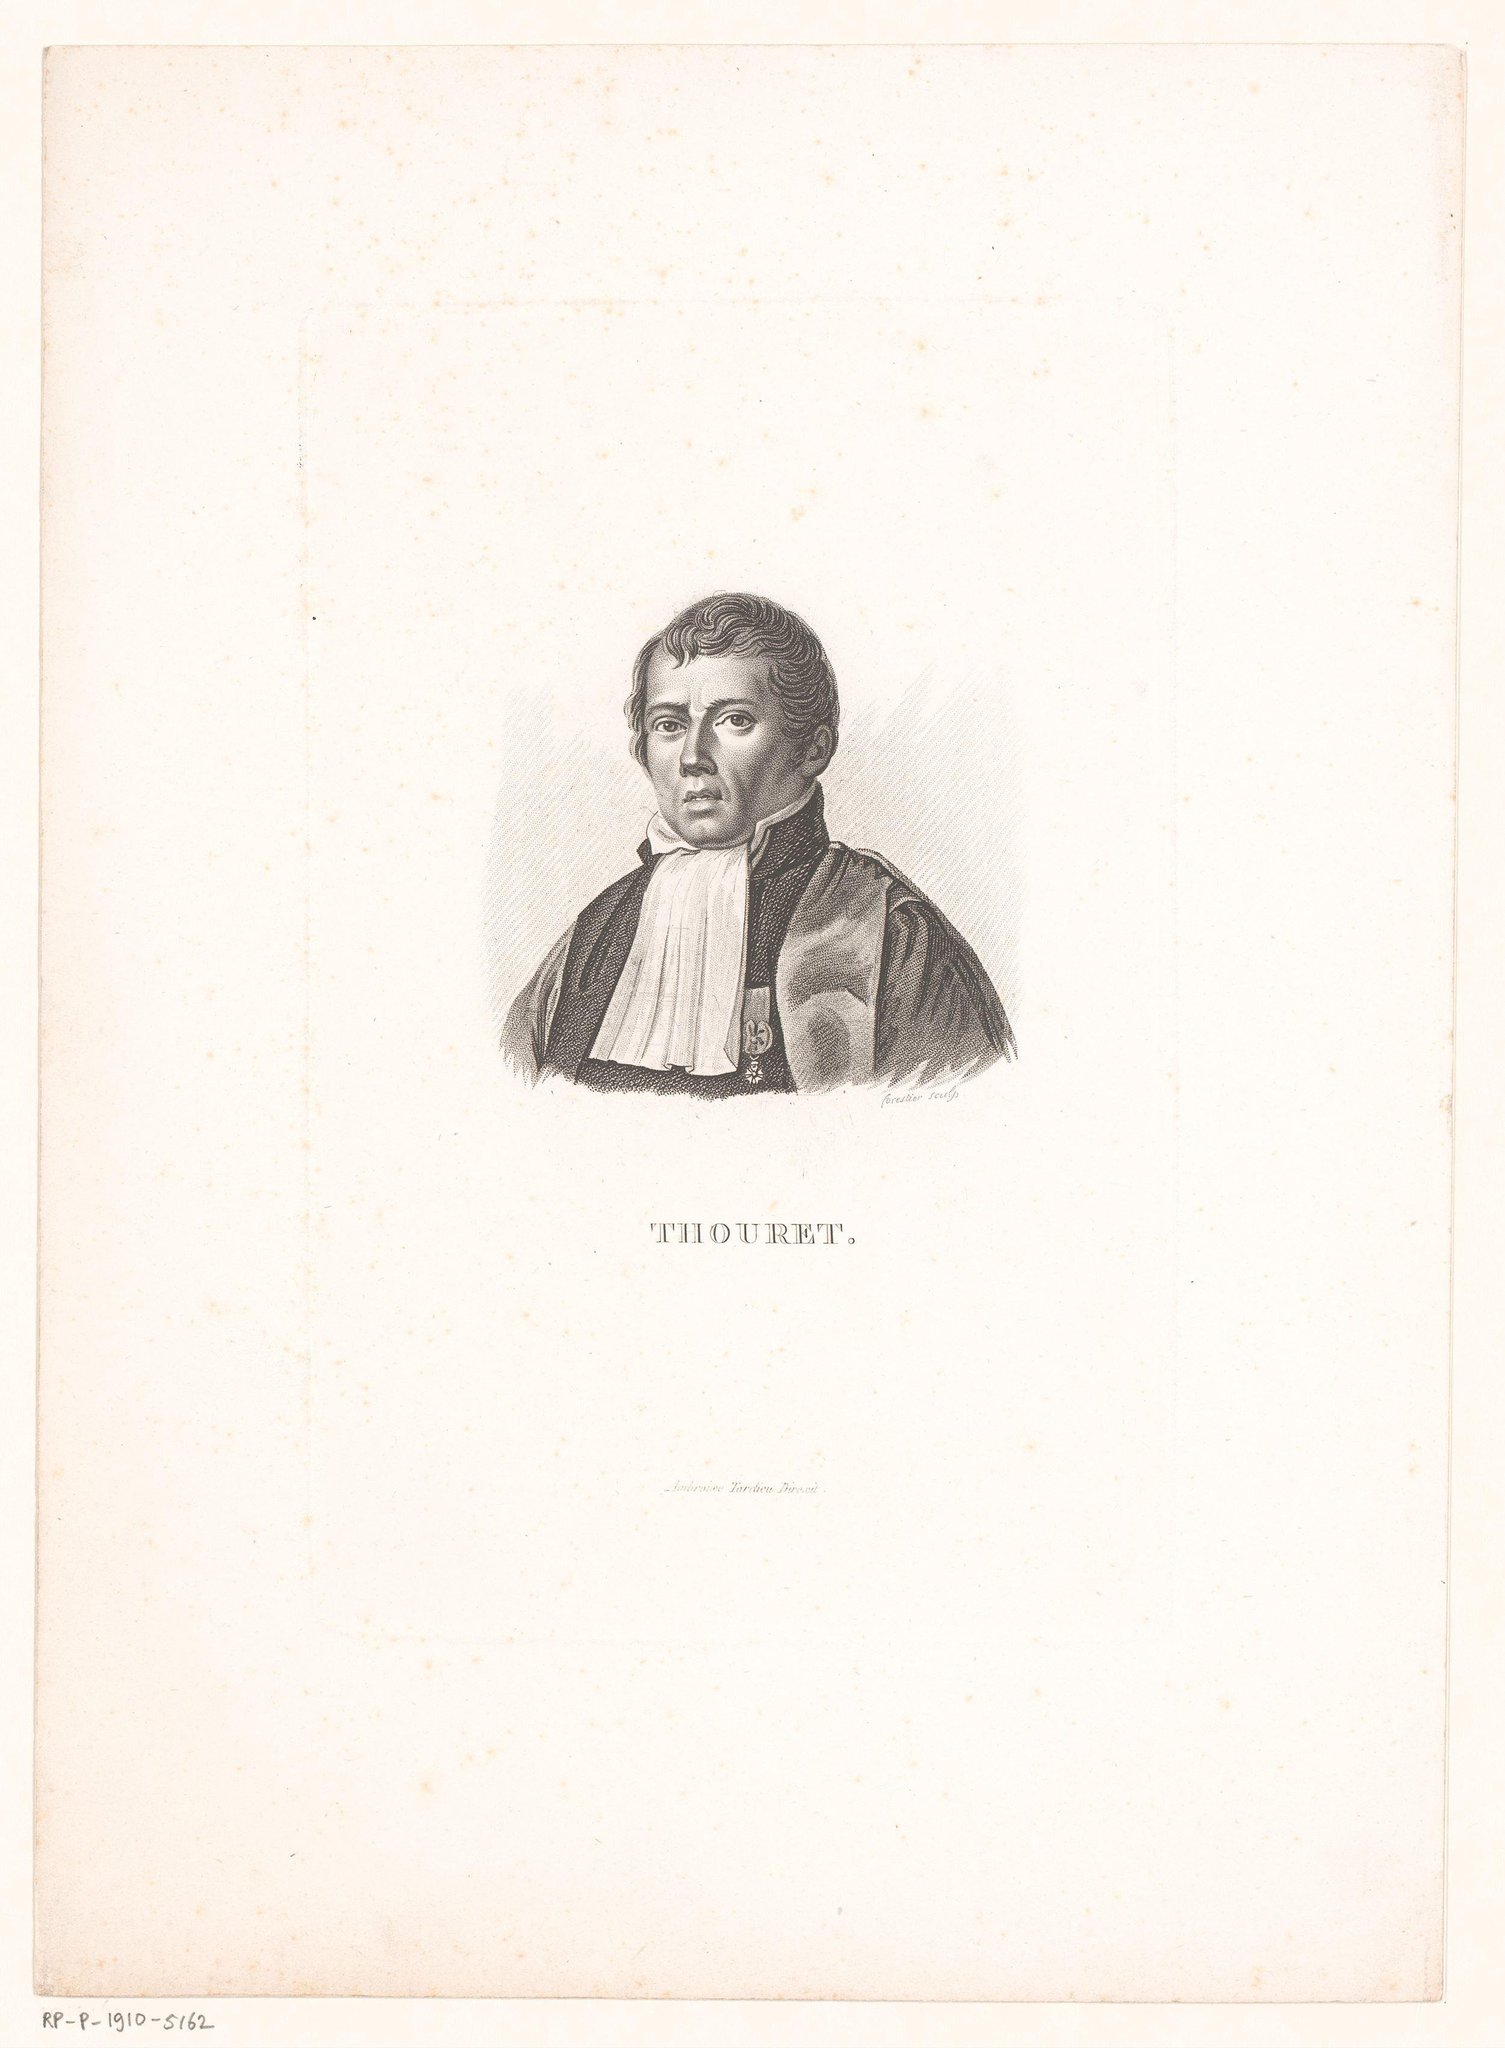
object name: book illustration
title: Portret van Michel-Augustin Thouret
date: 1818-1832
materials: paper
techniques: engraving, roulette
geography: france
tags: politician, historical persons, physician, doctor, politician, e.g. party leader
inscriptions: collector's mark: Lugt 2228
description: Mogelijk prent uit: Journal complémentaire du Dictionnaire des sciences médicales. Parijs: Panckoucke, Charles Louis Fleury, 1818-1832.